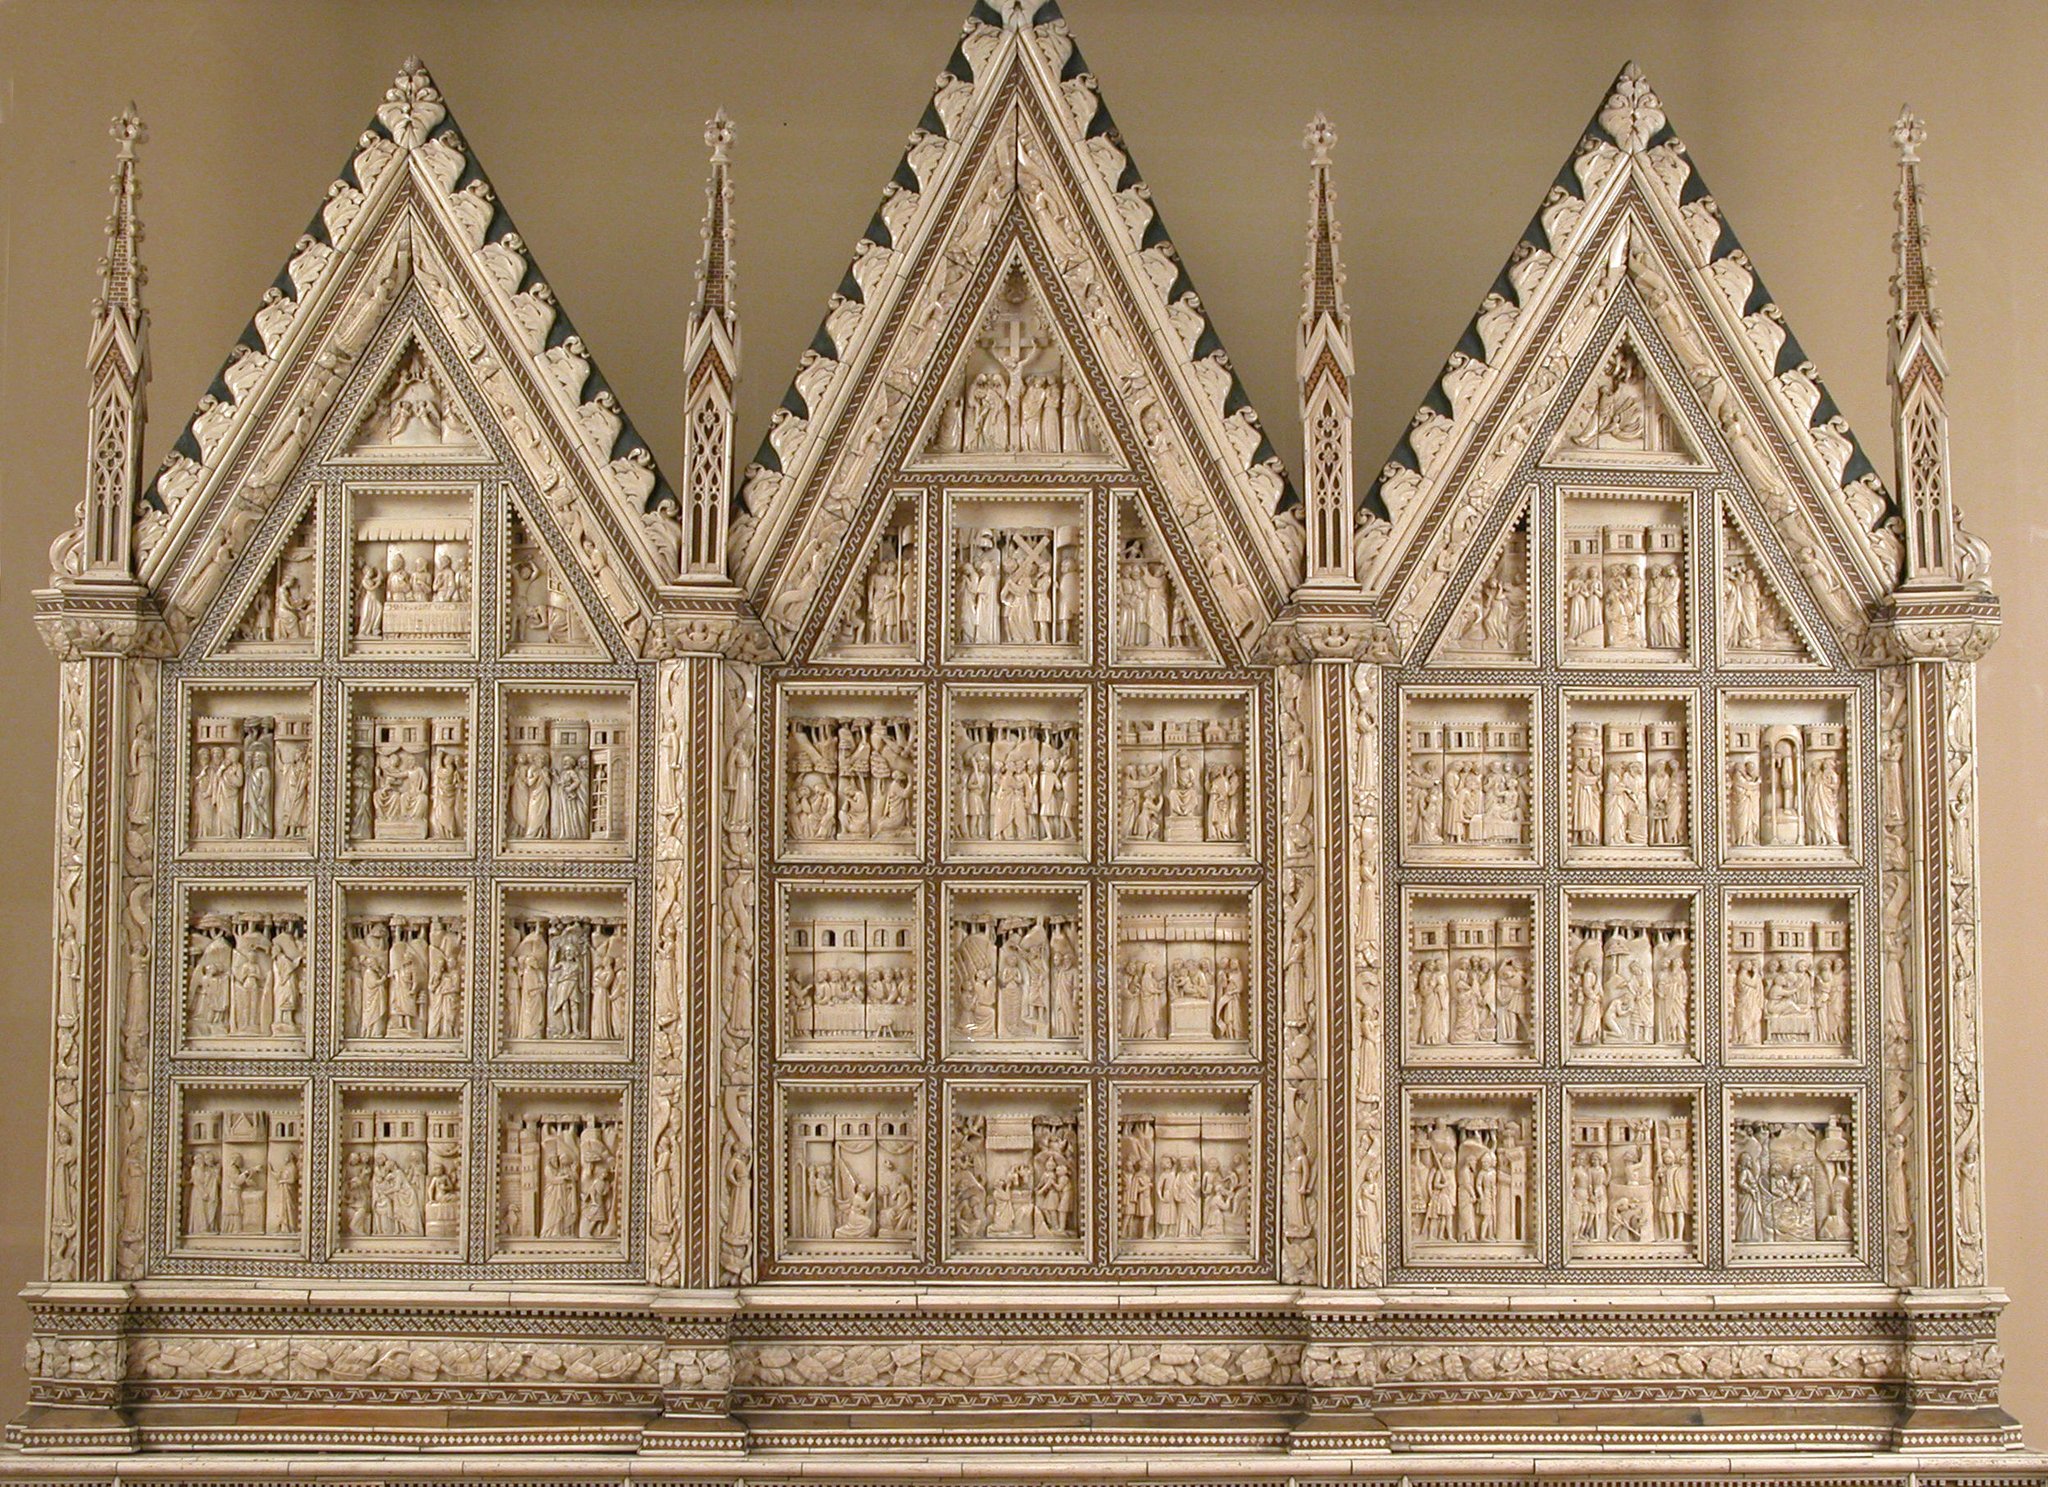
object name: altarpiece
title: Altarpiece with the Lives of Jesus, Saint John the Baptist, and Saint John the Evangelist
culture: north italian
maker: baldassare degli embriachi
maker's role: artist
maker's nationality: italian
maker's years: 1390-1409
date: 1390-1400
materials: bone, horn, paint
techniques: gilding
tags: christ,saint john the baptist,saint john the evangelist,annunciation,bearing the cross,crucifixion,nativity